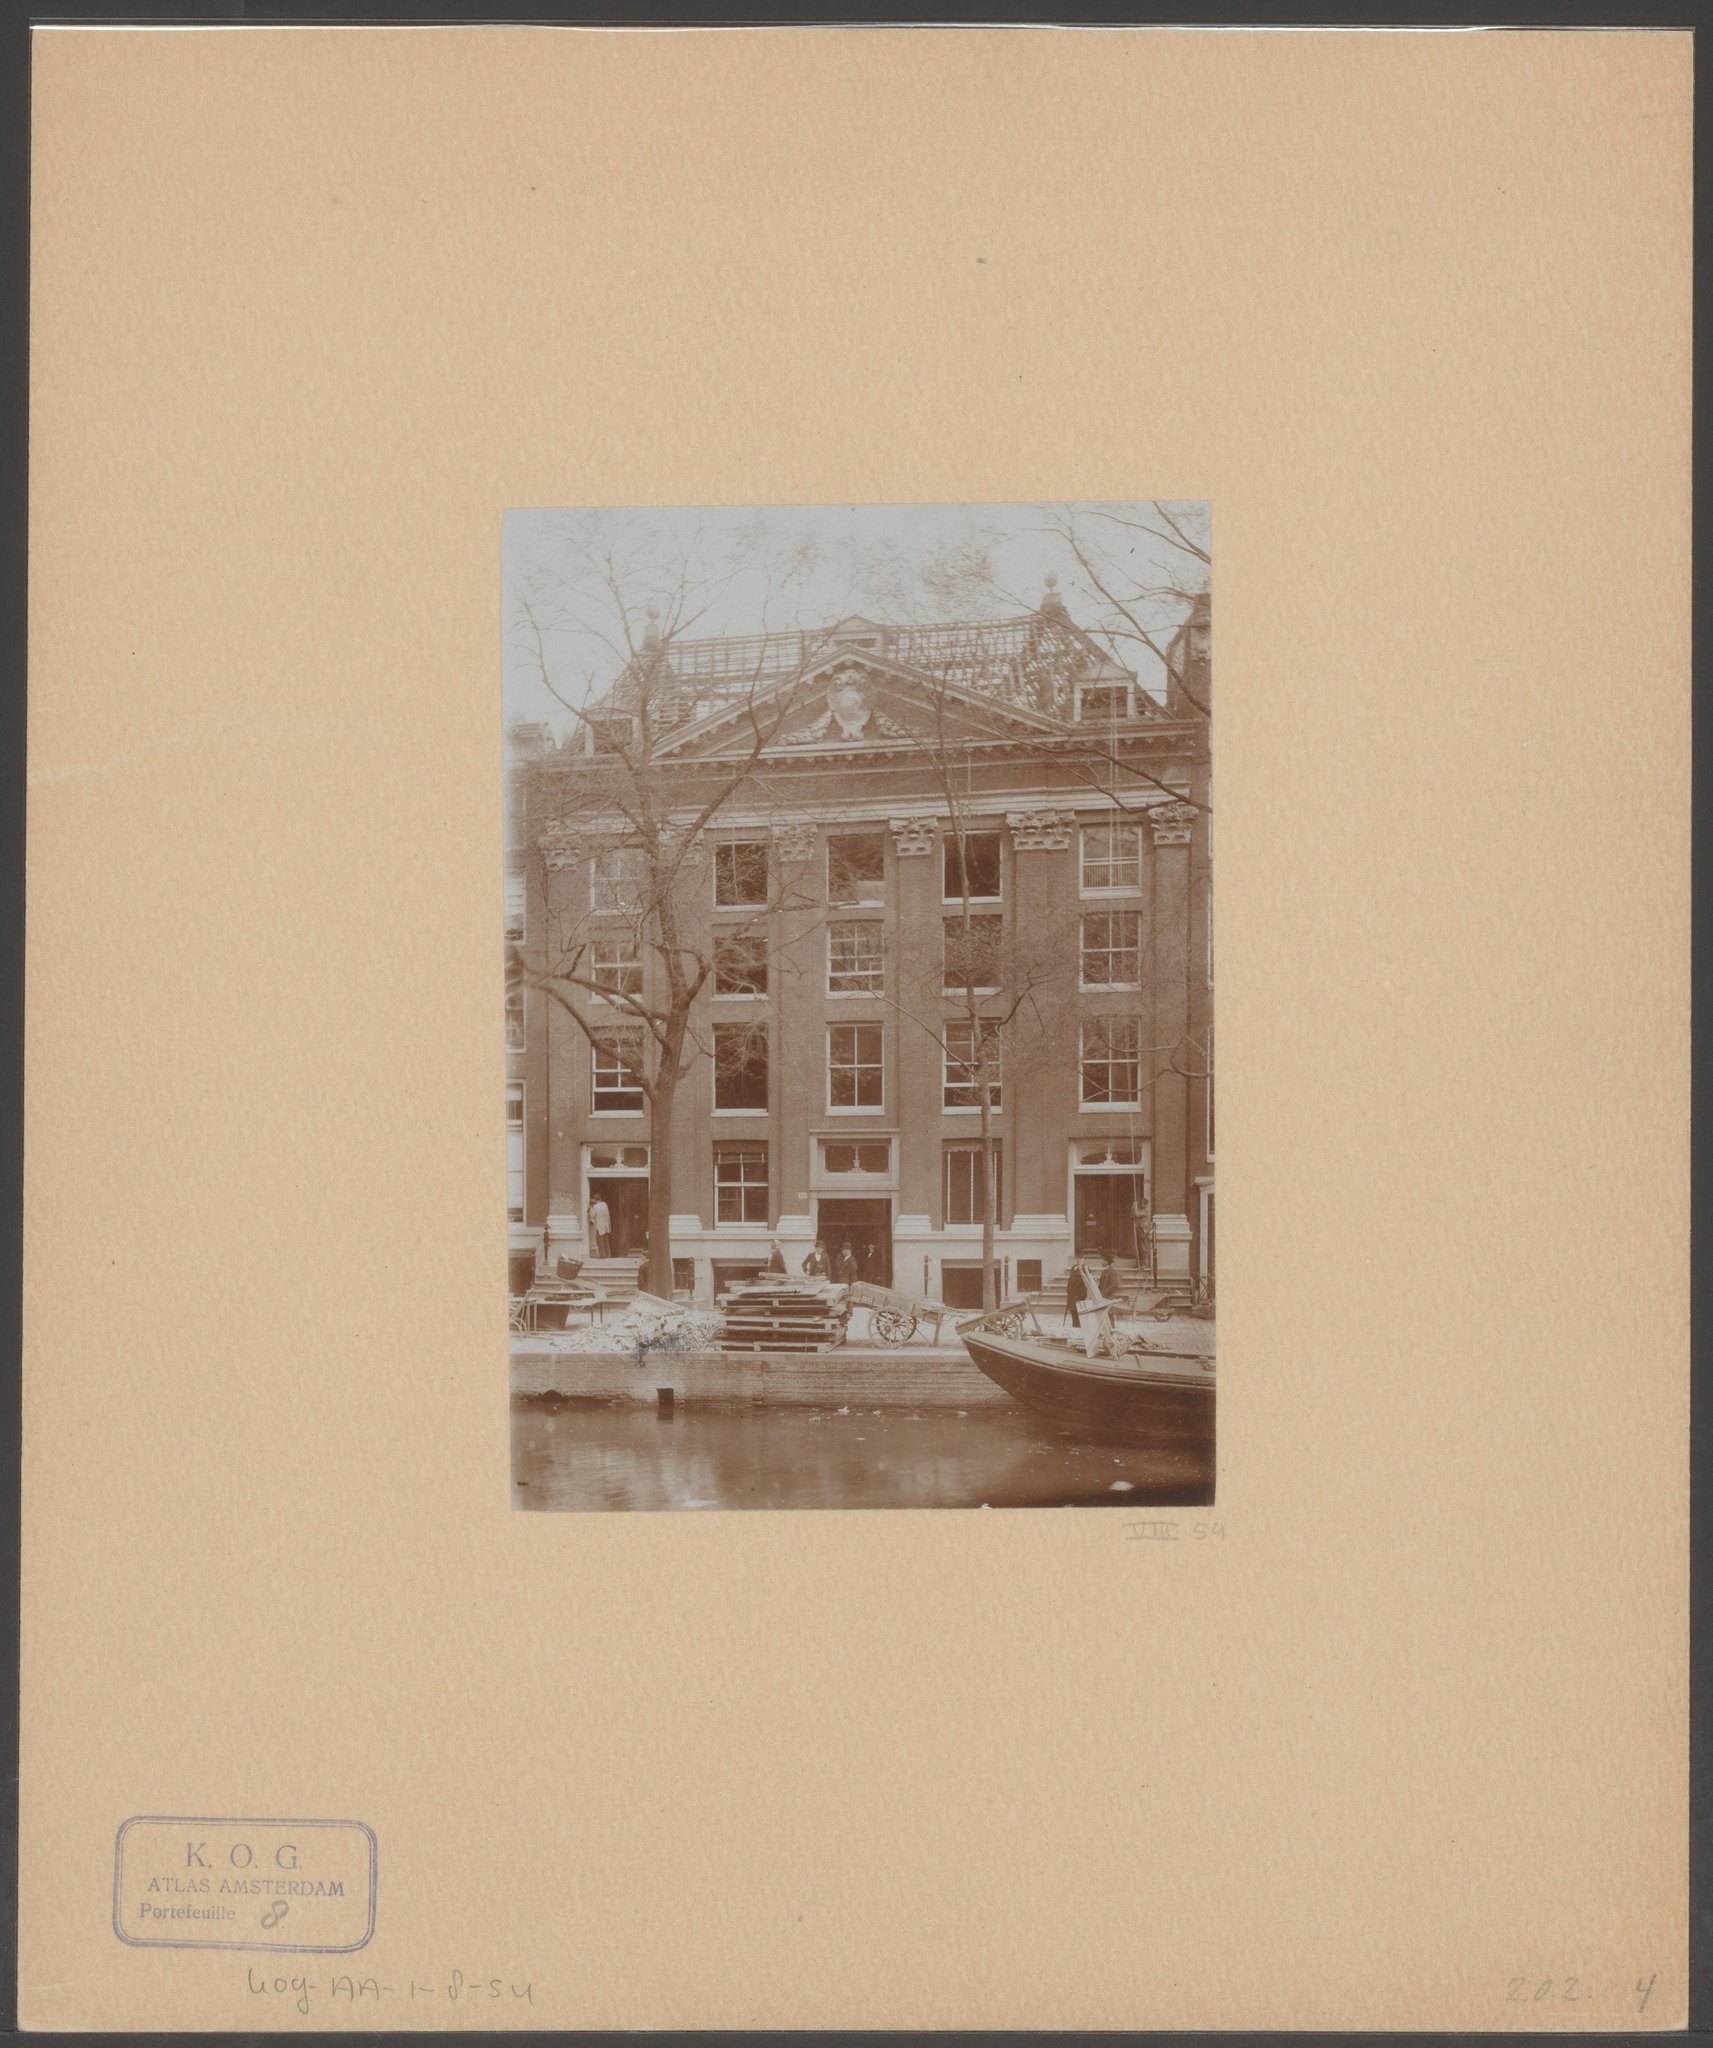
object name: photograph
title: Gezicht op de Associatie Cassa aan de Herengracht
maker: Anonymous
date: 1901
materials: paper, cardboard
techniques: collodion silver print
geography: amsterdam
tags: city-view in general; 'veduta', canal, demolition of building, the usual house or row of houses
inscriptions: inscription: ‘De in 1901 (...) Leliestraat en Driekoningenstraat’, collector's mark: ‘8’ Lugt 1641b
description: Onderwerpsrubriek binnen de Atlas Amsterdam: Haarlemmerplein, Halvemaansteeg, Handboogstraat, Handelskade, Haringpakkerij, Hartenstraat, Hasseltsteeg (Dirk van), Heerengracht.